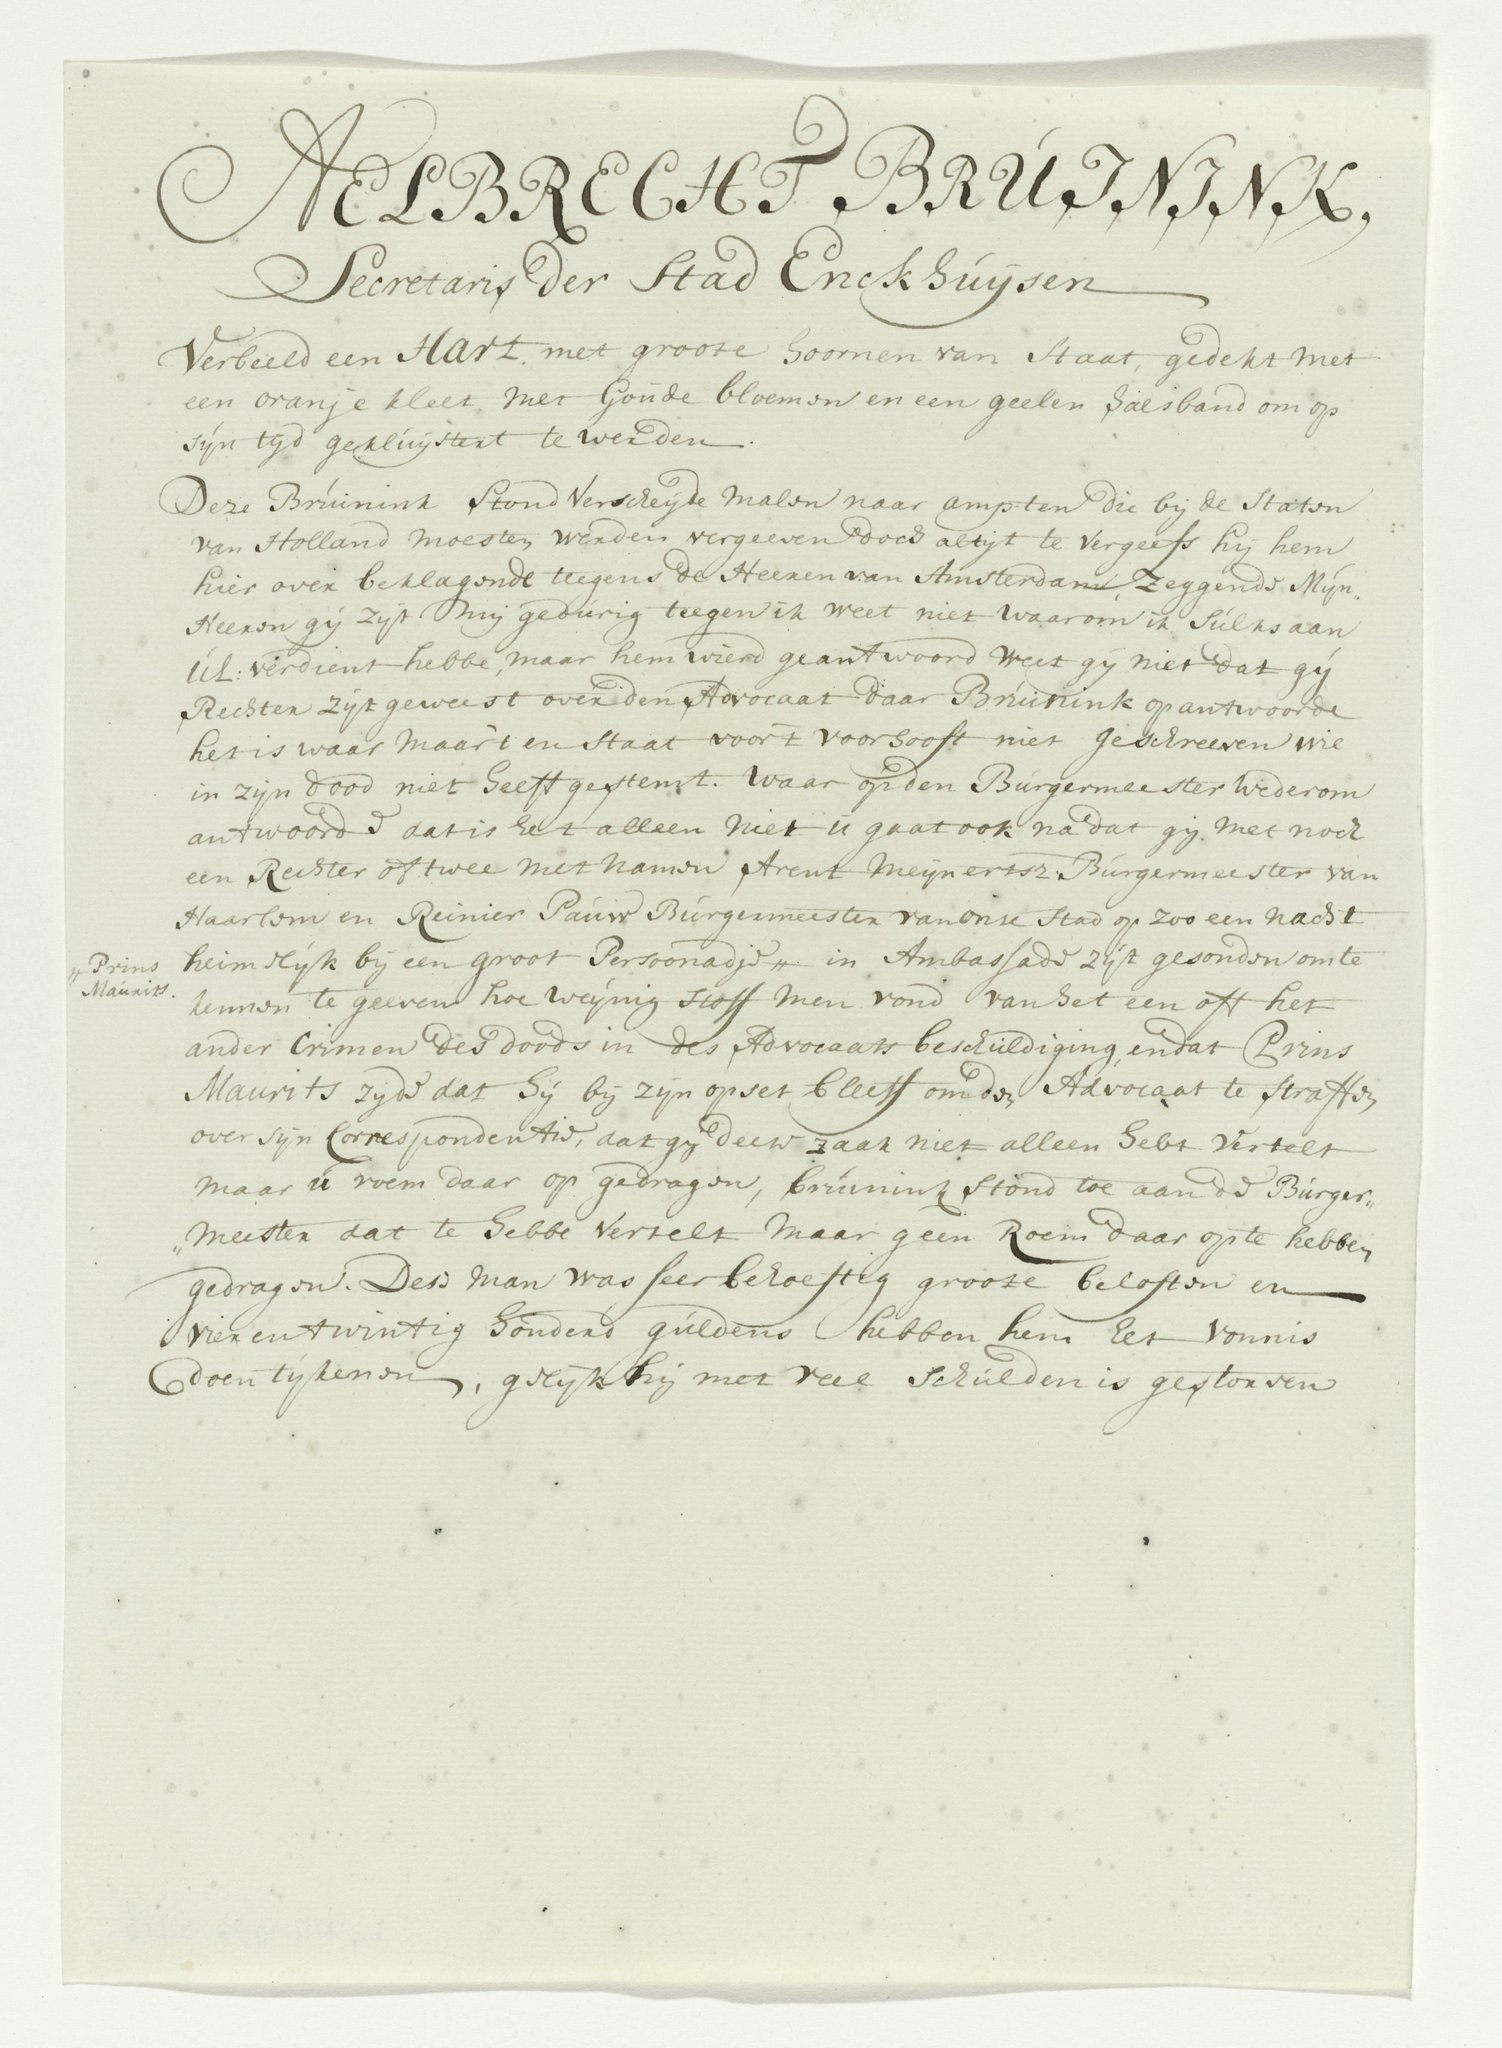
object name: poem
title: Spotvers bij het portret van Aelbrecht Bruynink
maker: Anonymous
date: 1710-1720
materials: paper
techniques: pen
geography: netherlands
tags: the hague, johan van oldenbarnevelt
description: Spotprent van Aelbrecht Bruynink, rechter van Van Oldenbarnevelt; hert met gewei en oranje mantel met om nek wapen, in krans van bloemen en bladeren. Daaronder cartouche waarin naam en daarboven nr. 14. Behorende bij serie aquarellen in boek.